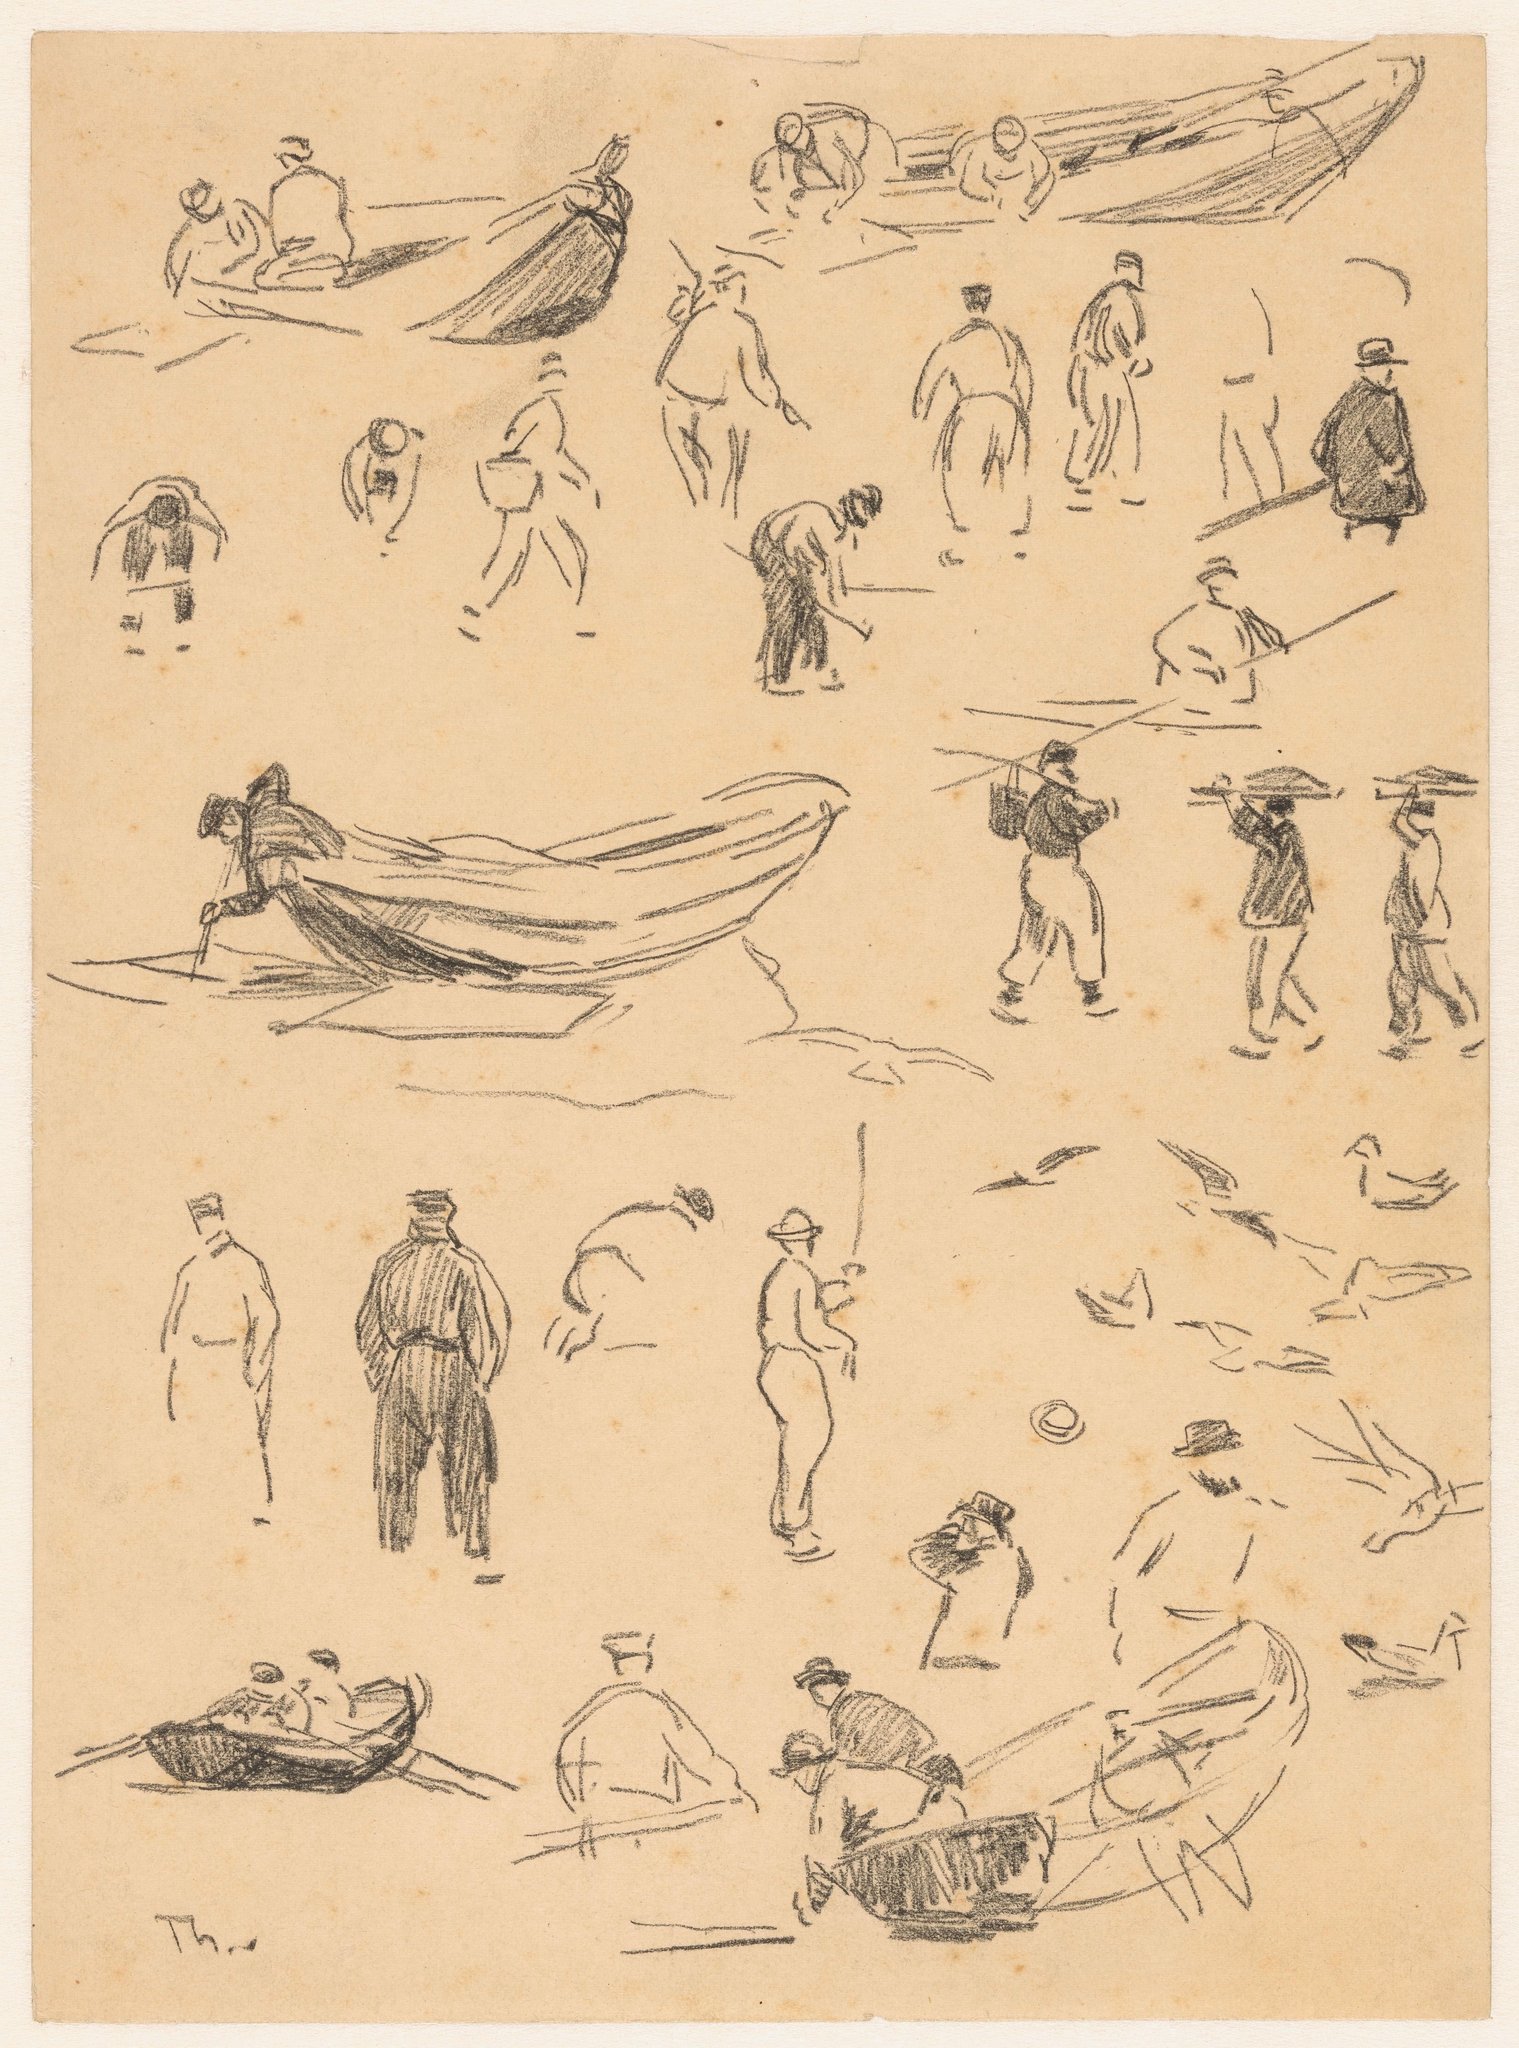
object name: drawing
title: Studieblad met diverse figuurstudies, vissersbootjes en studies van meeuwen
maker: willem bastiaan tholen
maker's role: draughtsman, painter, print maker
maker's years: 1860-1931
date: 1870-1931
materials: chalk, paper